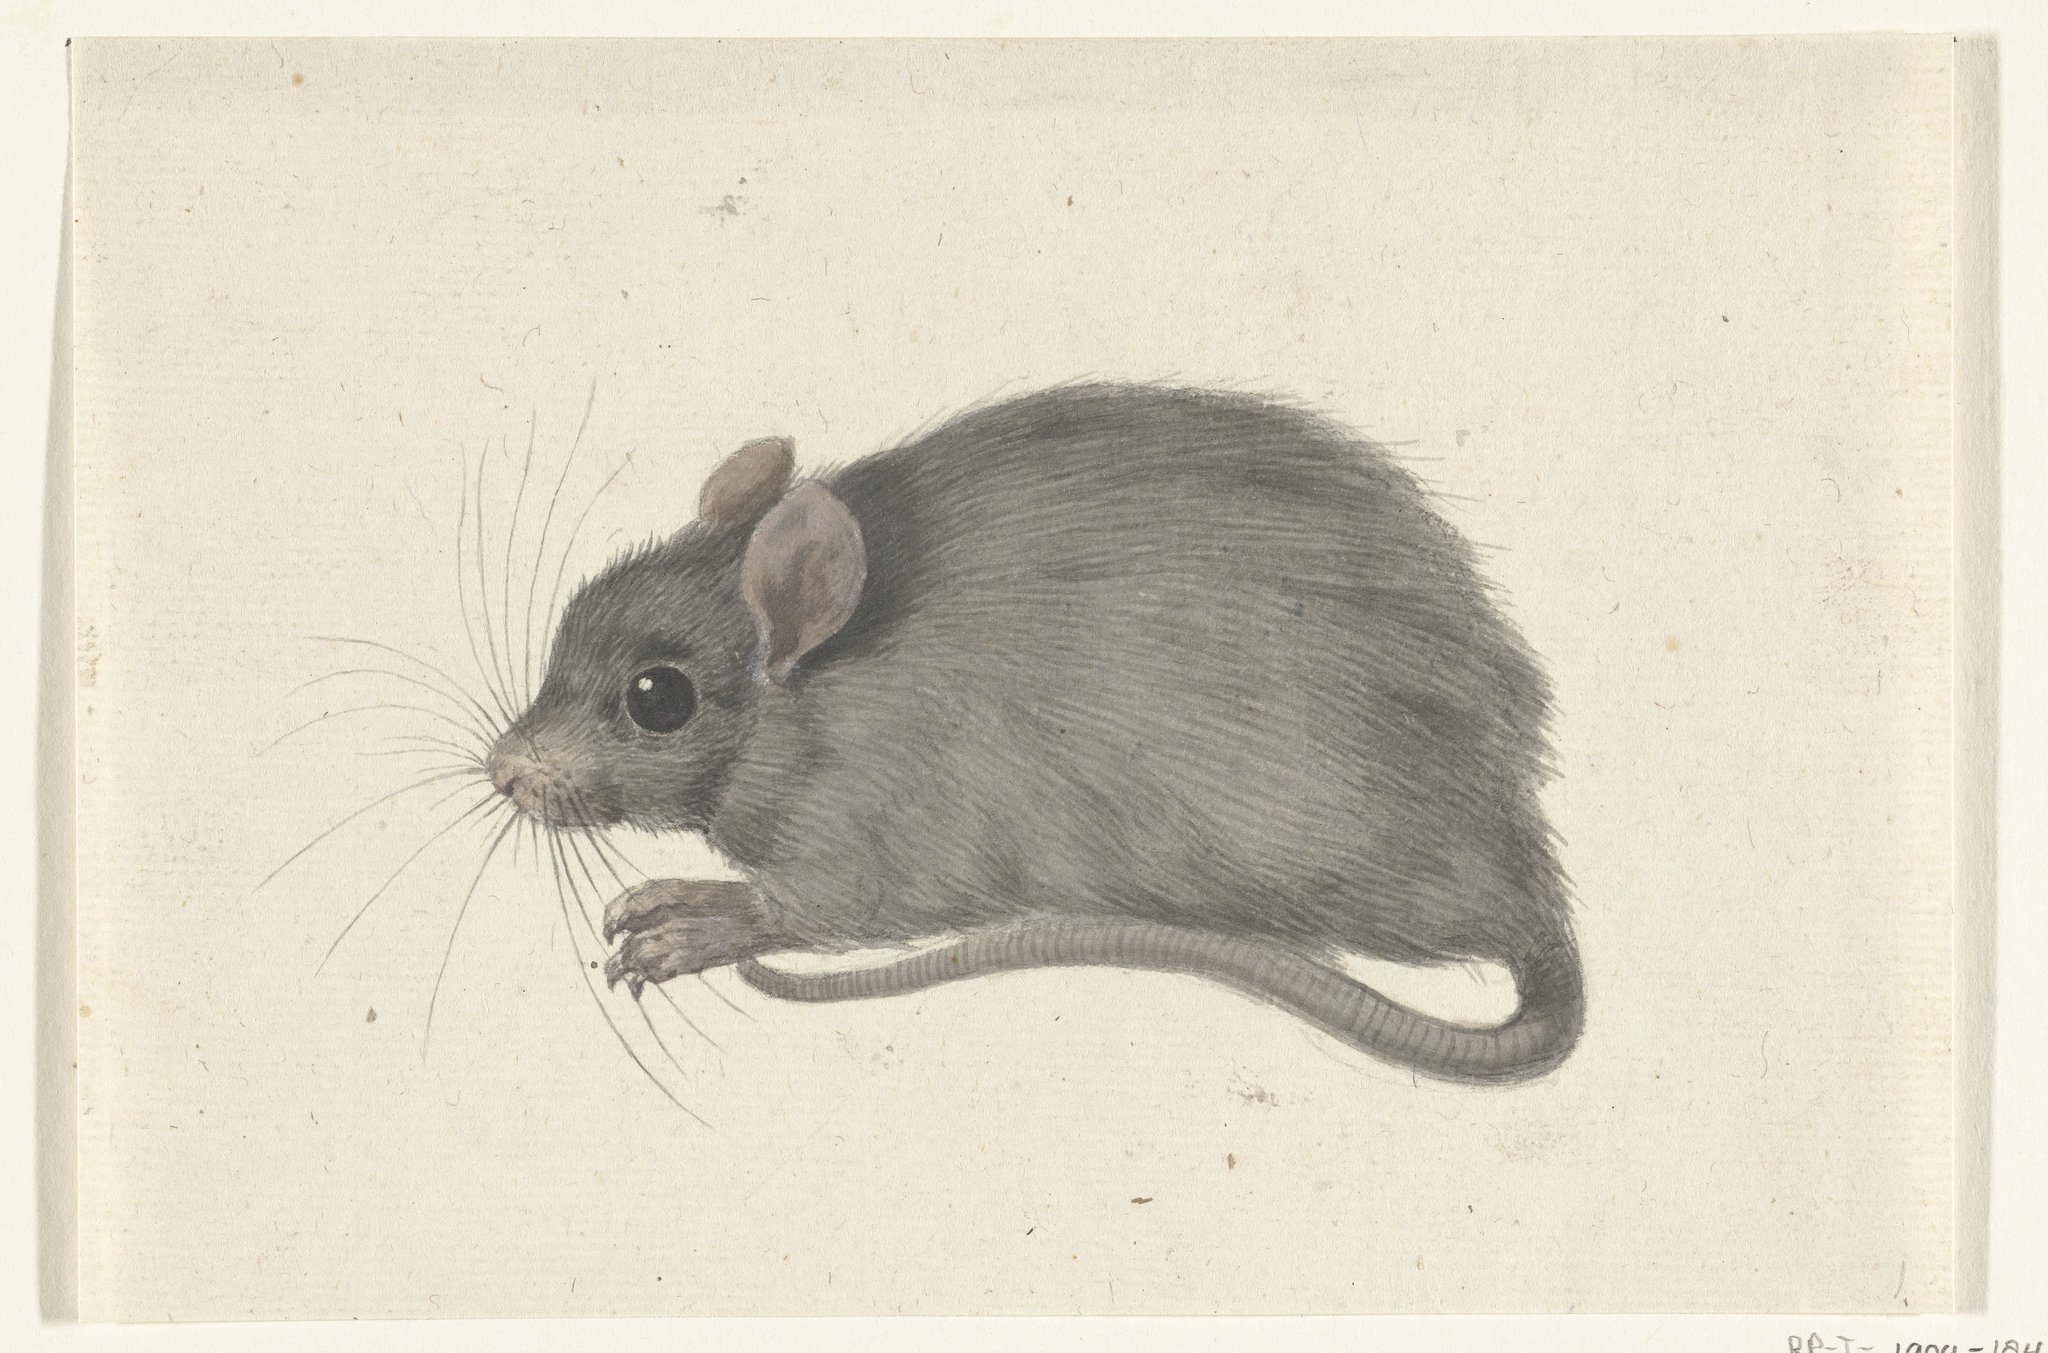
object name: watercolor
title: Muis, naar links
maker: jean bernard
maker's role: draughtsman, print maker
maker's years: 1765-1833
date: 1775-1833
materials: chalk, paper, watercolor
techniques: brush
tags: rodents: mouse